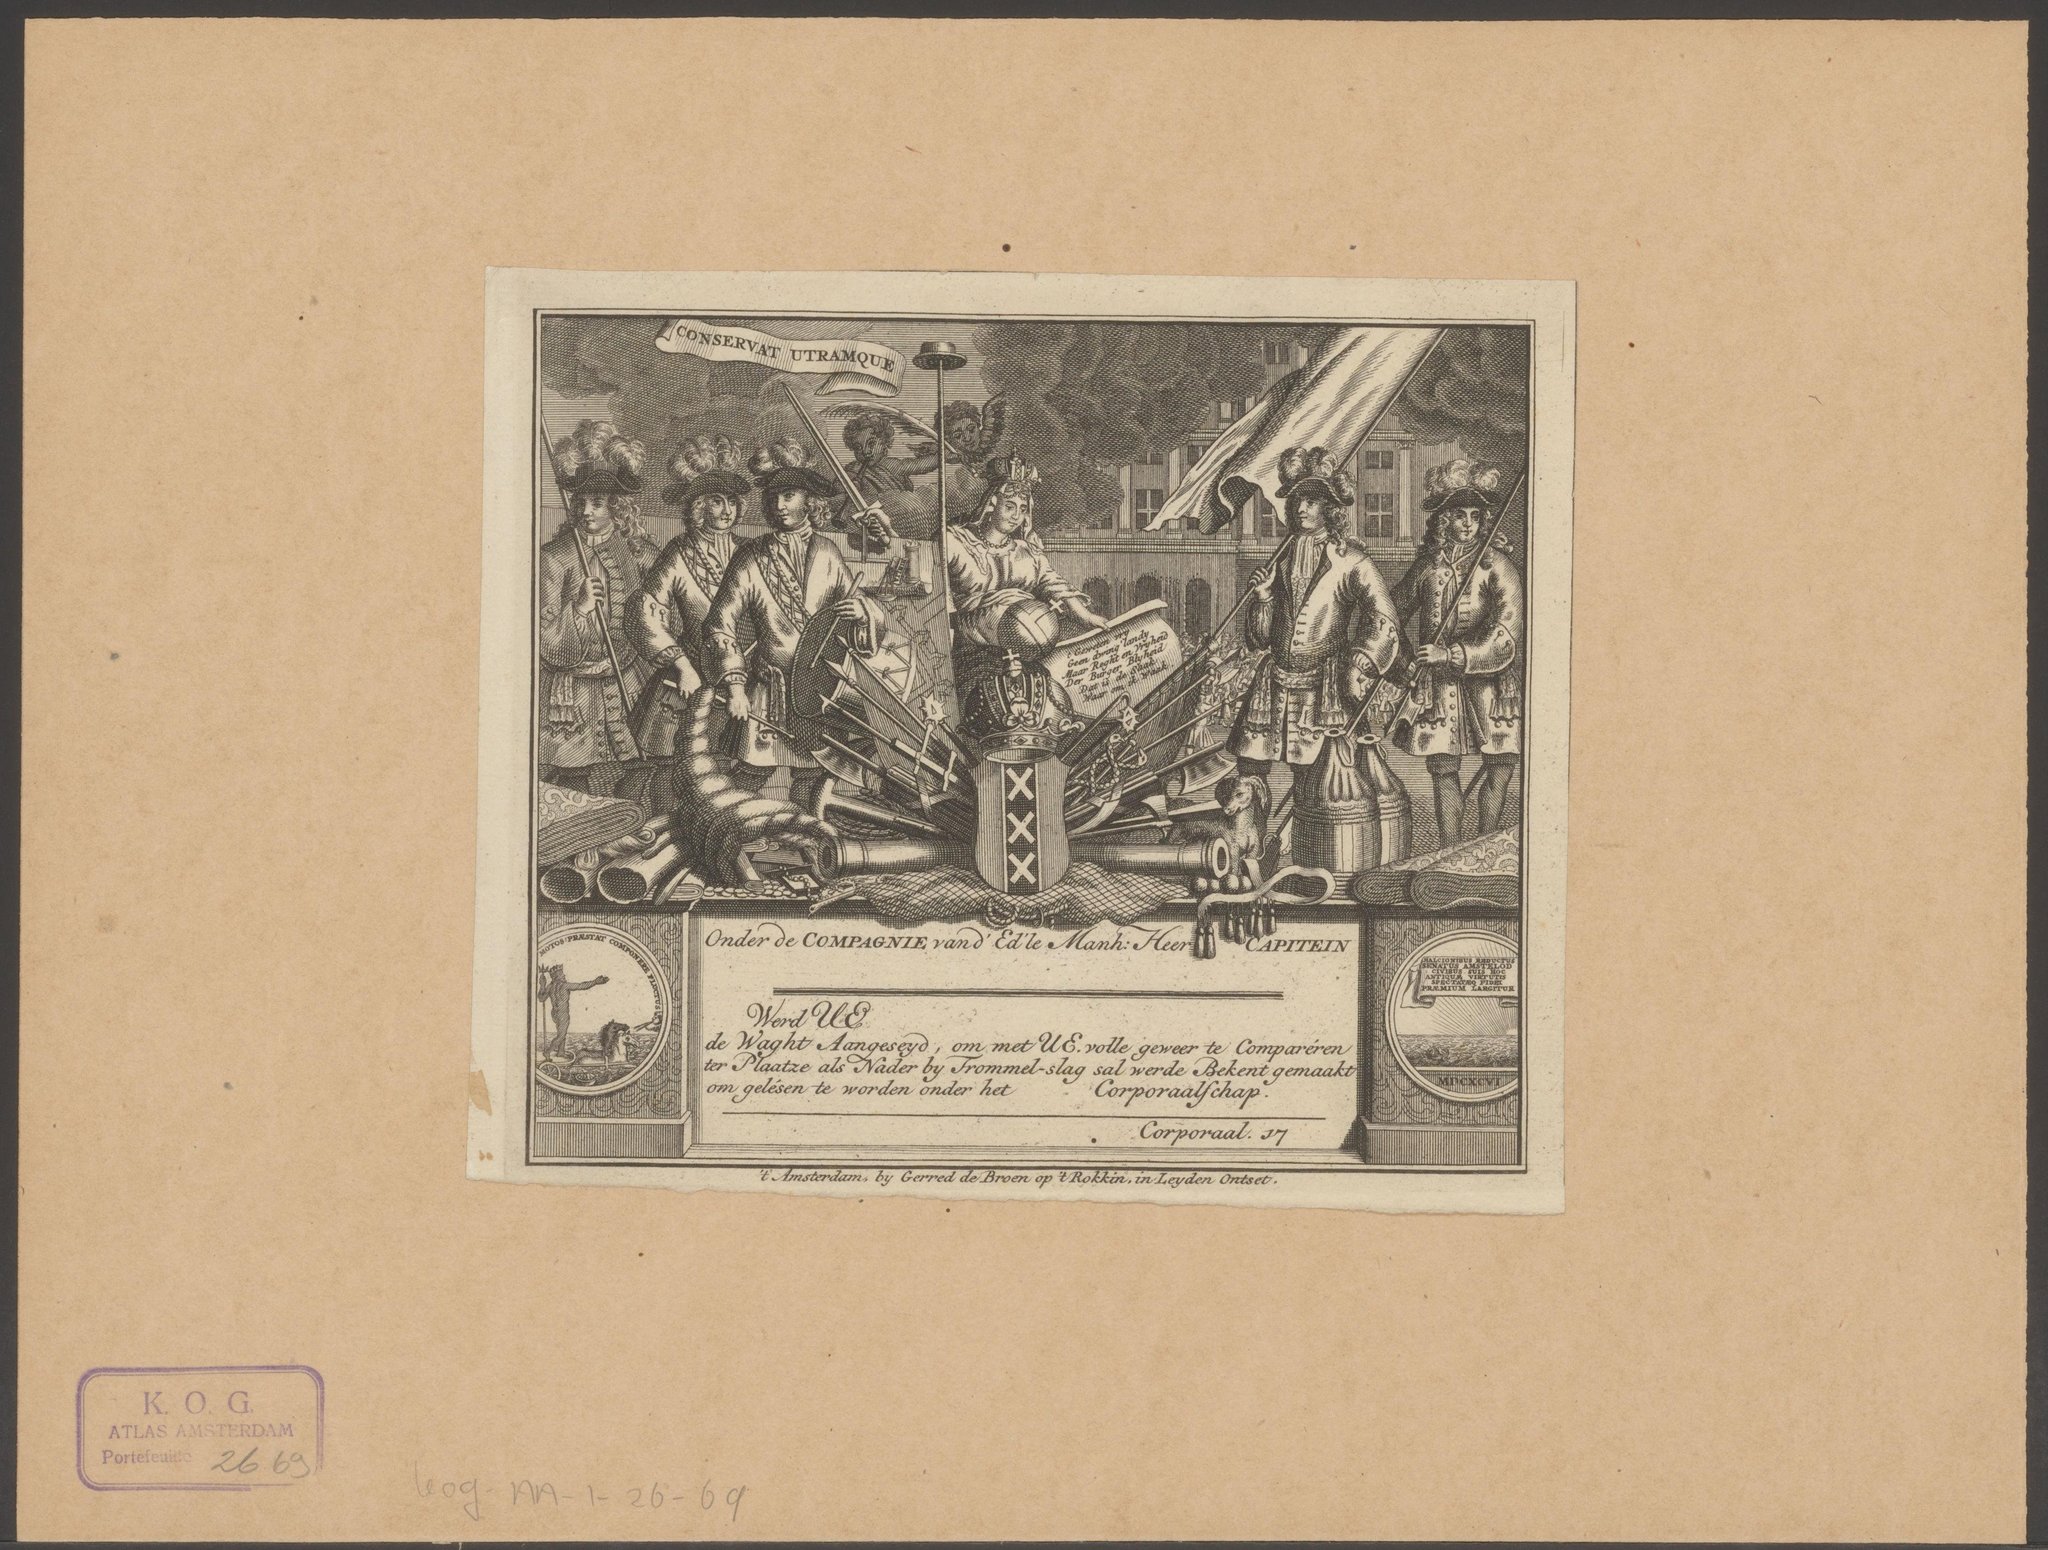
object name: schuttersbiljet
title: Schuttersbrief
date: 1741-1774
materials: paper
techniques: engraving, etching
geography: northern netherlands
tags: coat of arms (as symbol of the state, etc.) (+ city; municipal), personification of a city, town-patron(ess), military service (+ citizen soldiery, civil guard, citizen militia), amsterdam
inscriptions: collector's mark: Lugt 1641b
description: Onderwerpsrubriek binnen de Atlas Amsterdam: Schutters-oproepingsbriefjes.